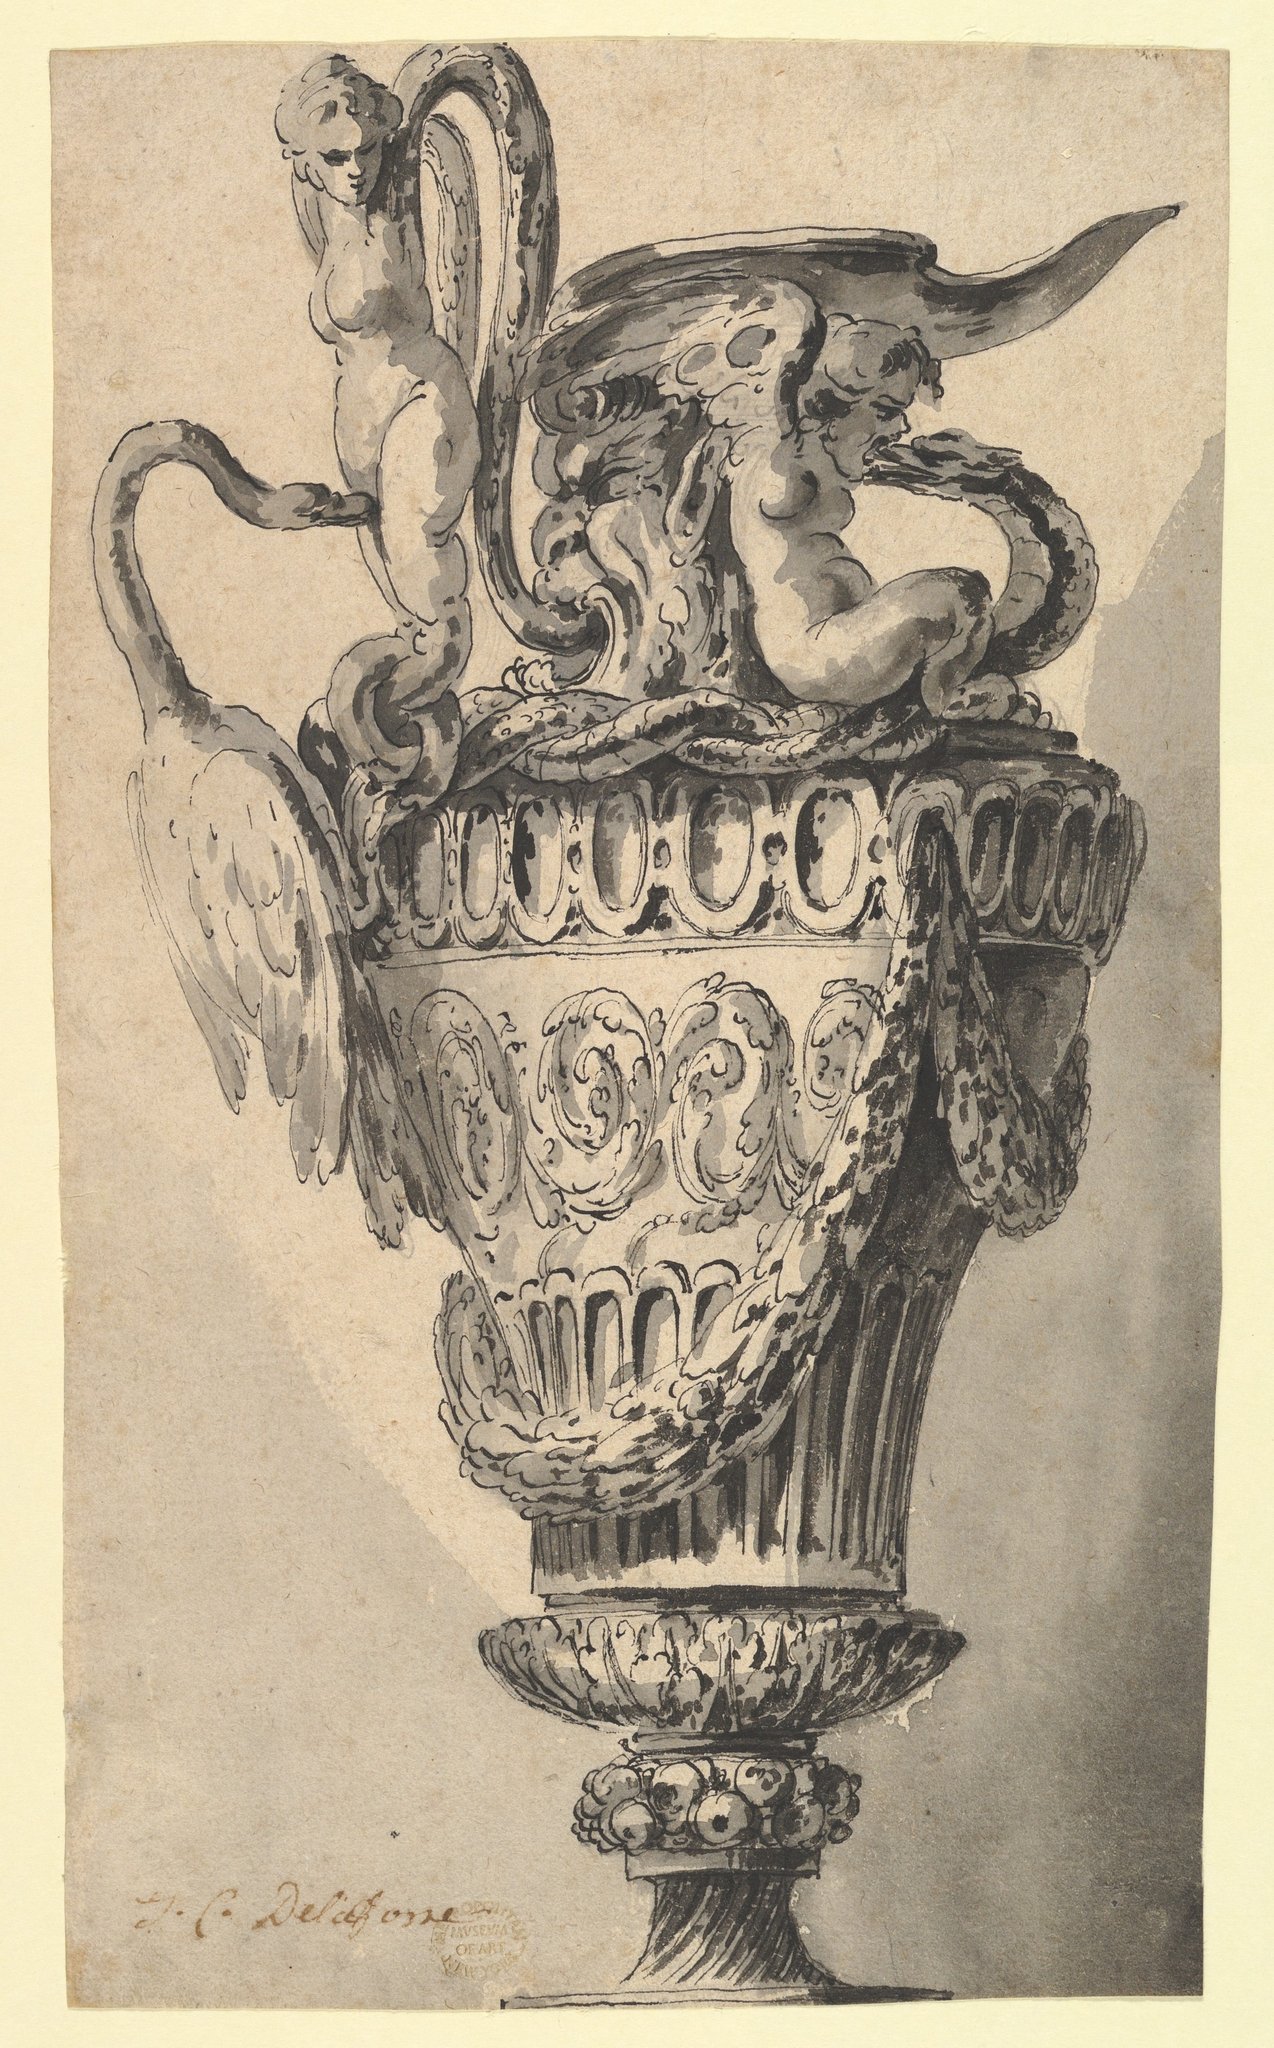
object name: drawing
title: Design for a Ewer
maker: jean charles delafosse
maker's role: artist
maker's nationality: french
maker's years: 1734-1789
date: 1734-1791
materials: chalk, graphite, ink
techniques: brush, pen, drawing, wash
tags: birds,ewers